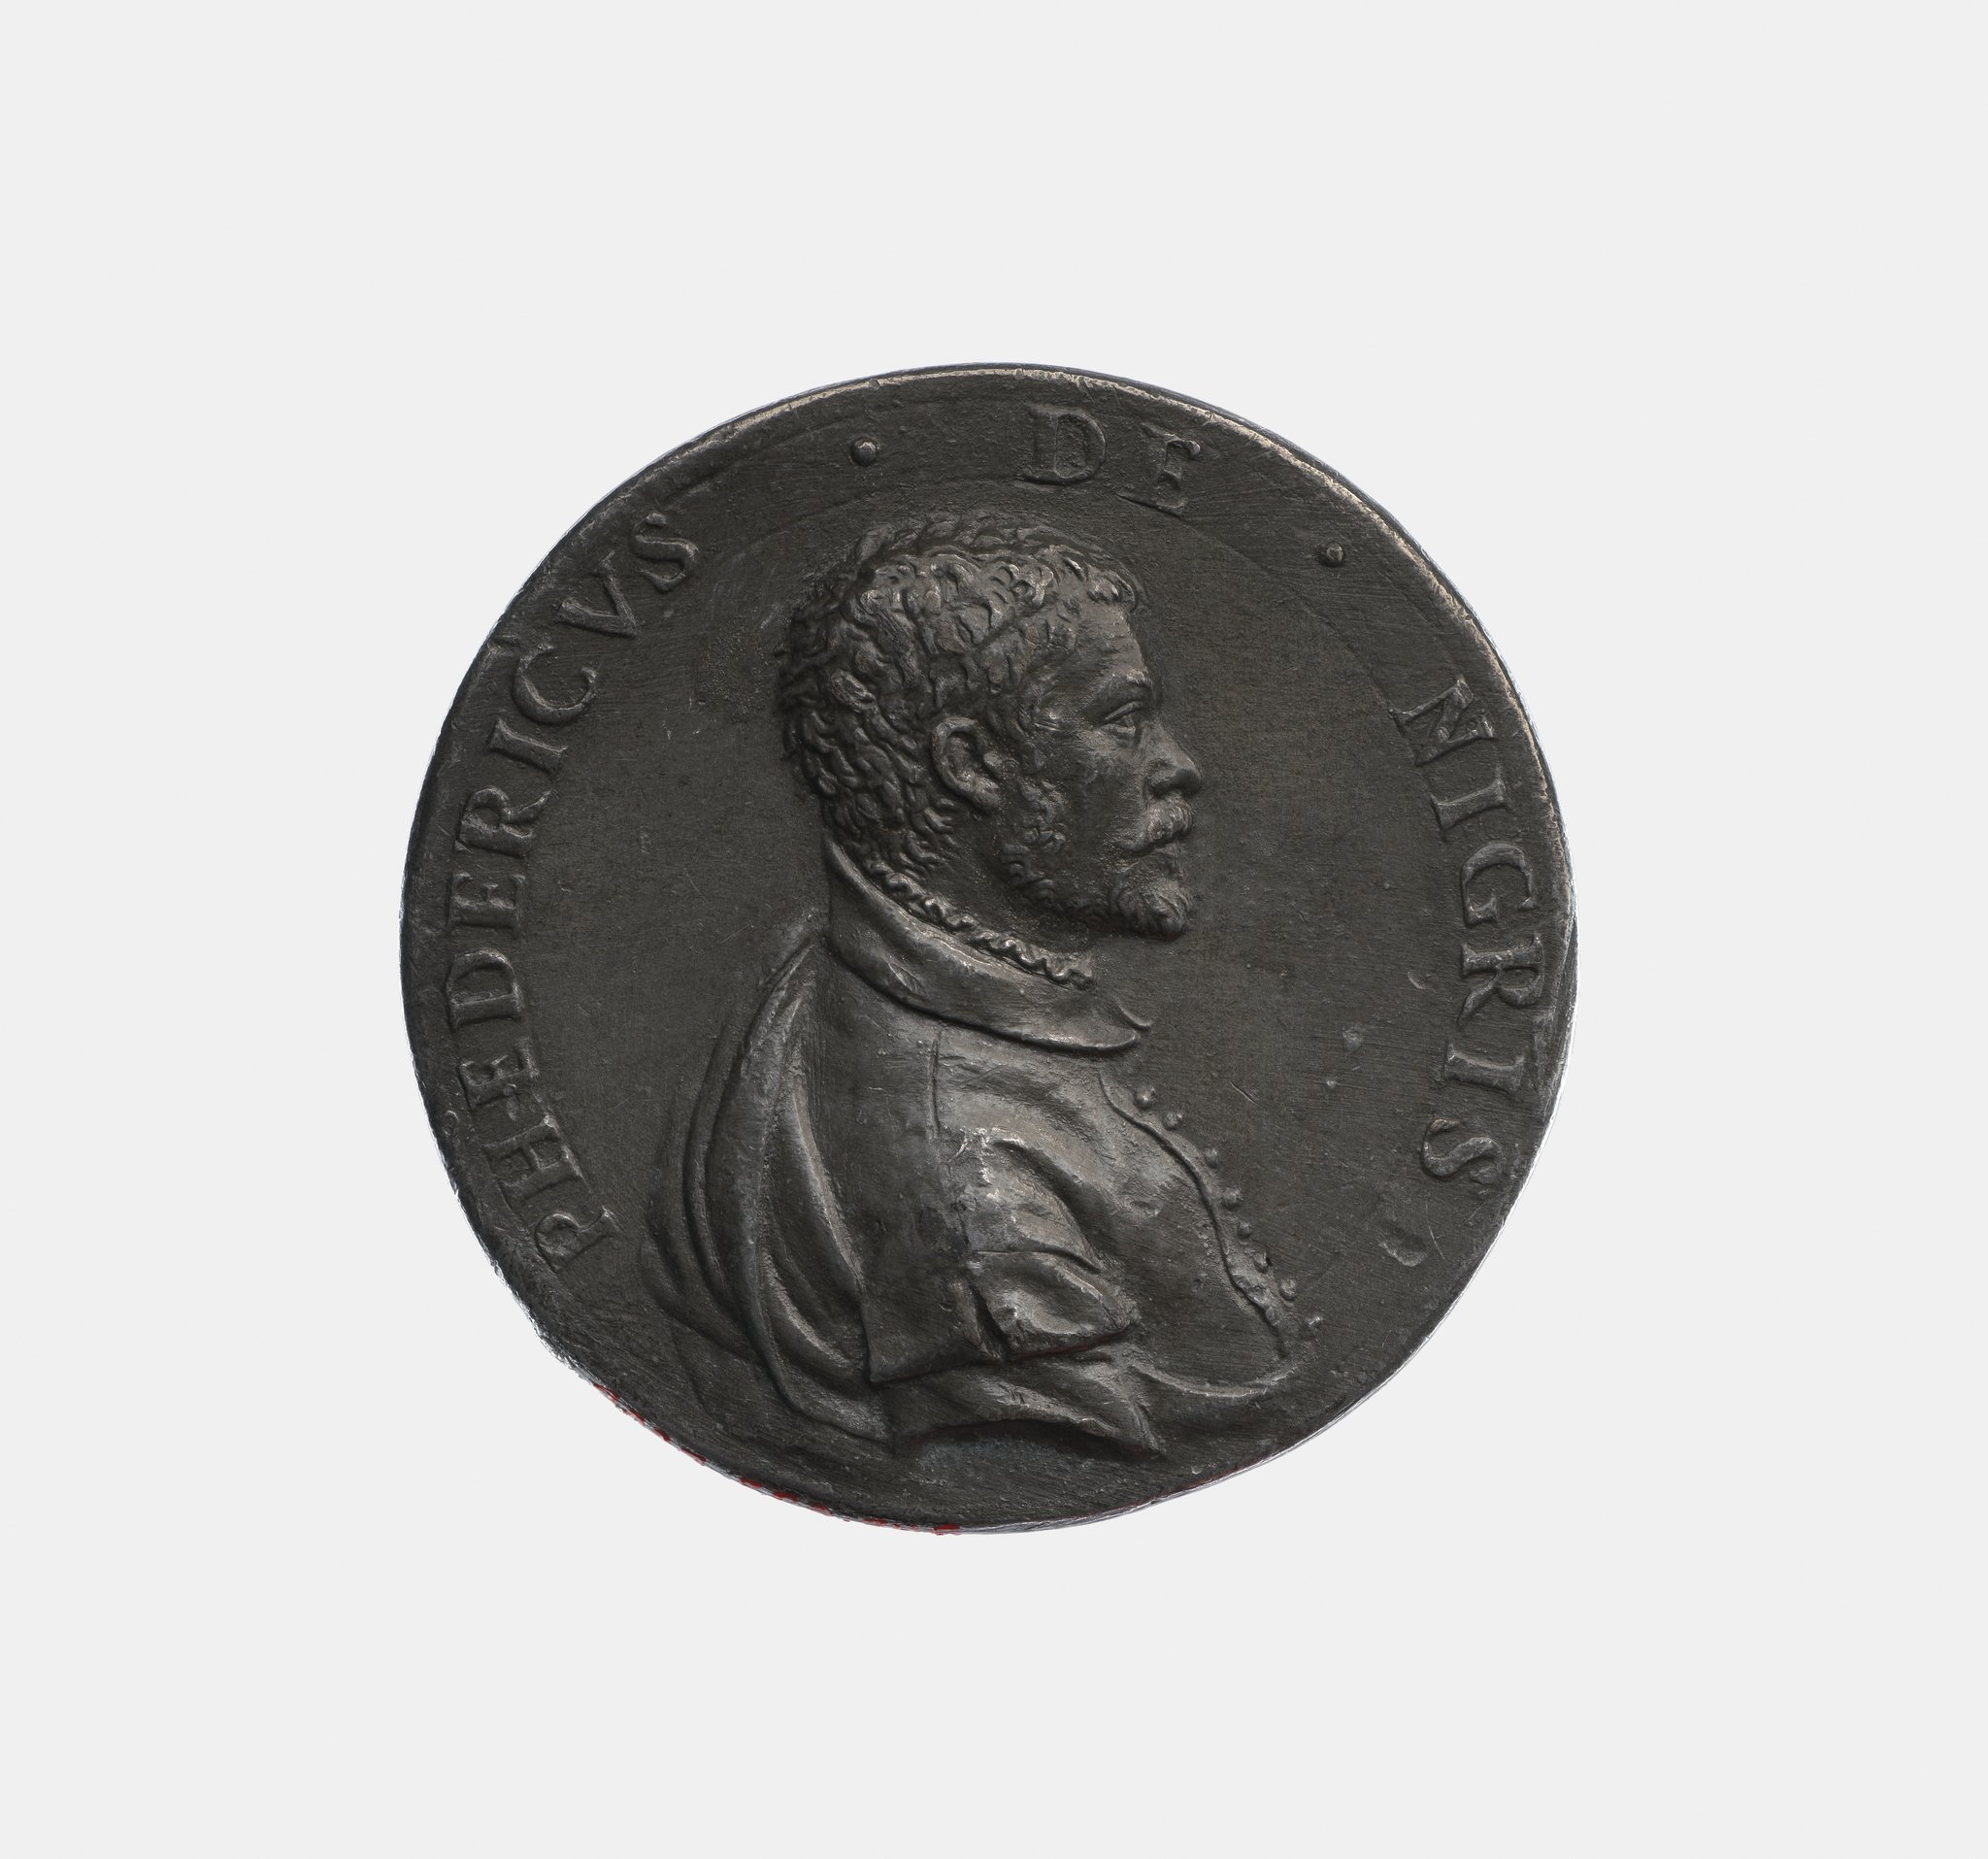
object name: medal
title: Federigo de’ Nigri (Peter Schwarz)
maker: Anonymous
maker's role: artist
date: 1534-1566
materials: lead